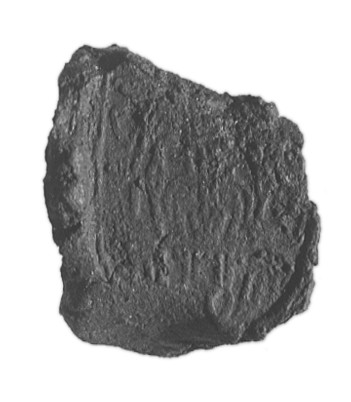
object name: sealing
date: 2030-1640 BCE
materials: clay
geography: egypt